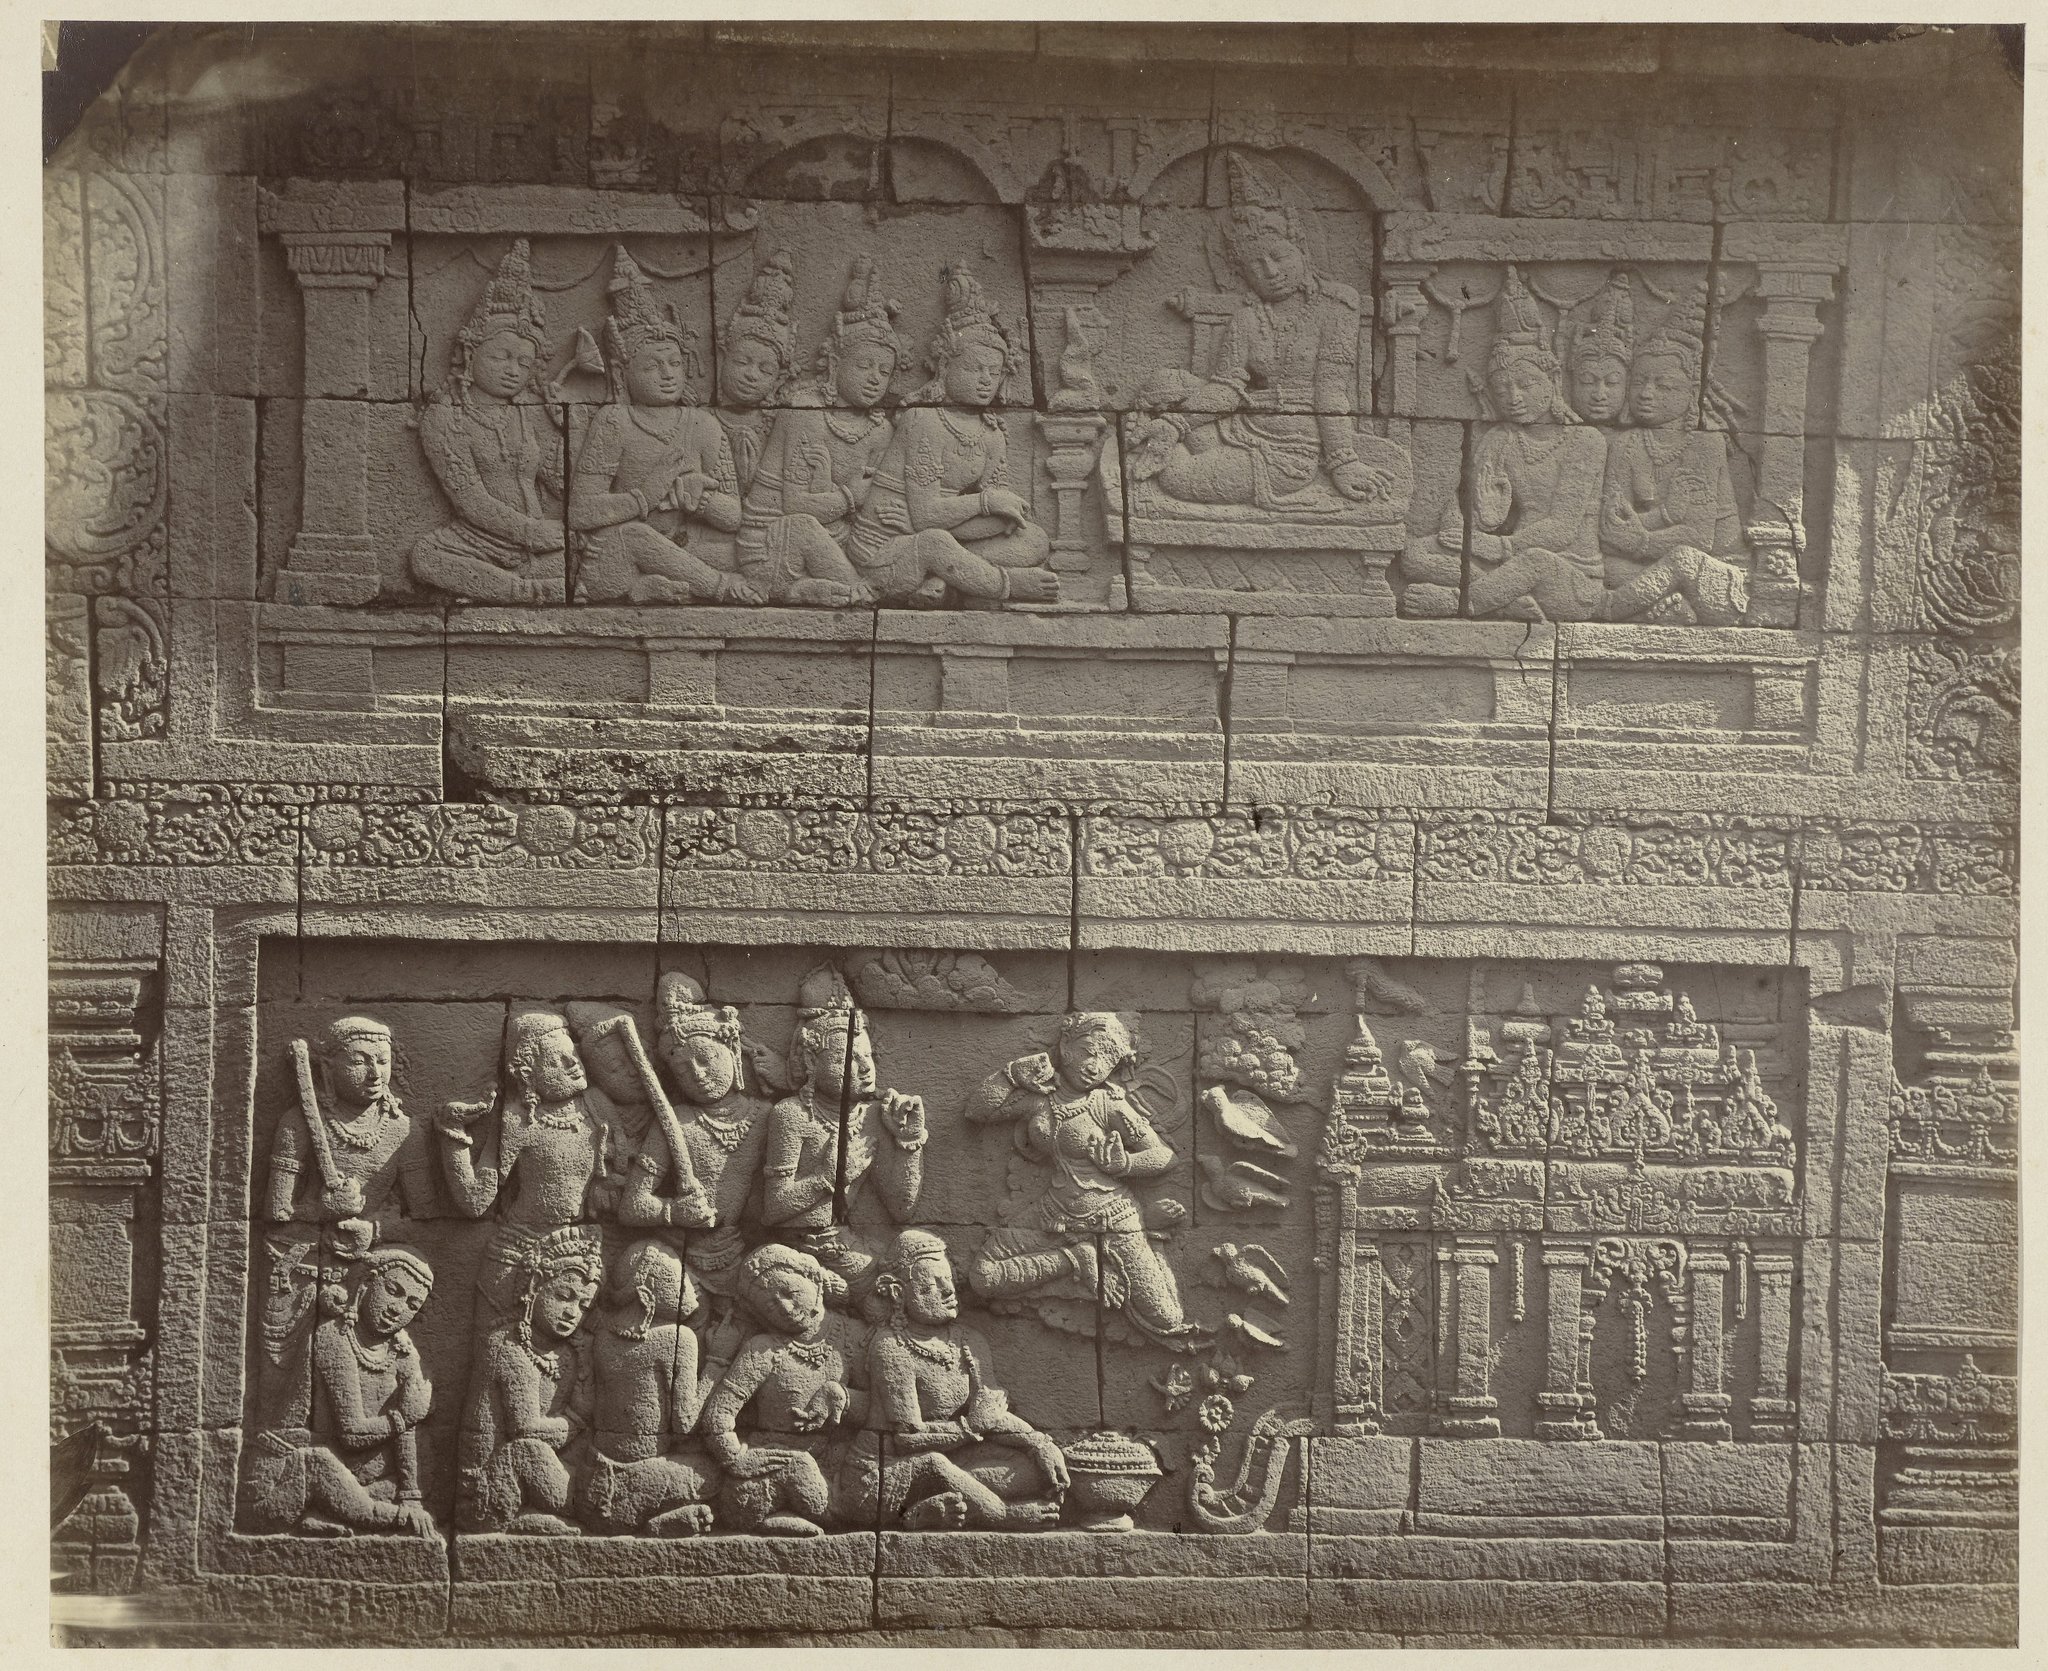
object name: photograph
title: Baseliëf in de muur aan de noordzijde van de Borobudur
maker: isidore kinsbergen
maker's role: fotograaf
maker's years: 1821-1905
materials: cardboard, paper, photographic support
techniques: albumen print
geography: java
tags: borobudur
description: Gallery I, main wall, east side 13 (top): Relief 1a-11, Lalitavistara relief, Bodhisattva Siddhartha receiving hommage from all Bodhisattvas in the Tusita heaven. 16 (bottom): relief 1b-11, Avadana relief, Manohara story, Sudhana brings the tribute of the rebels to his father. Borobudur village, Magelang district, Central Java province, 778-824 AD.